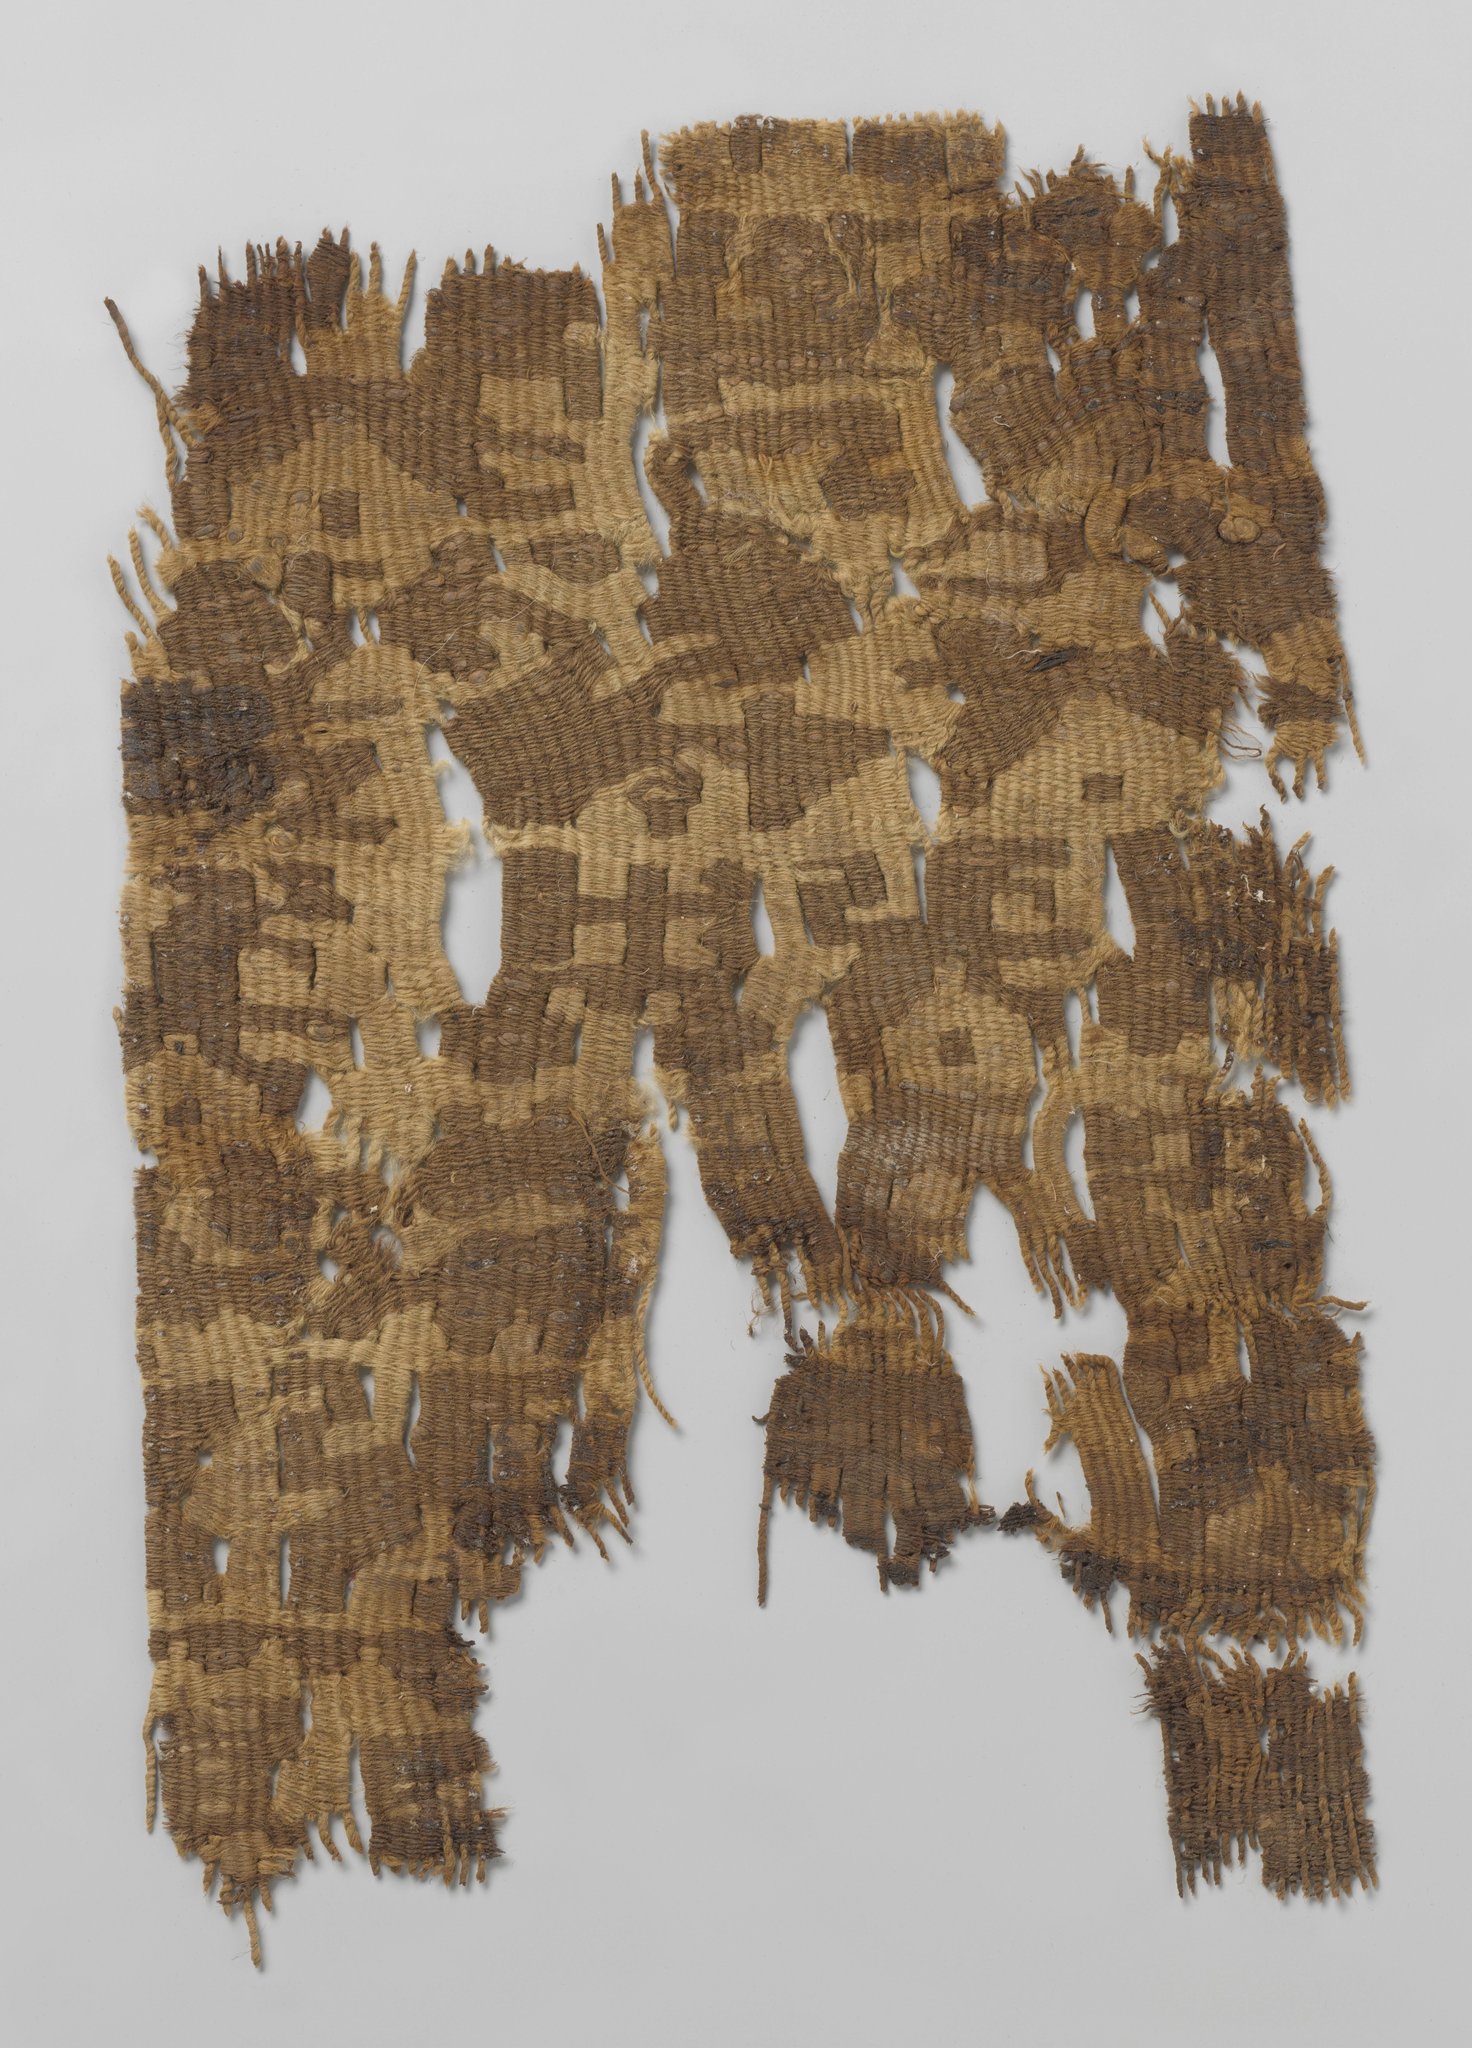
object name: fragment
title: Weefselfragment in tapijtwerk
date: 700-1399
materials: wool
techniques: tapestry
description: Verwant fragment in collectie van Musée de Cluny Parijs (zie A. Lorquin, Les tissus coptes au musée national du Moyen Age - Thermes de Cluny, Parijs 1992, cat. nr. 100).